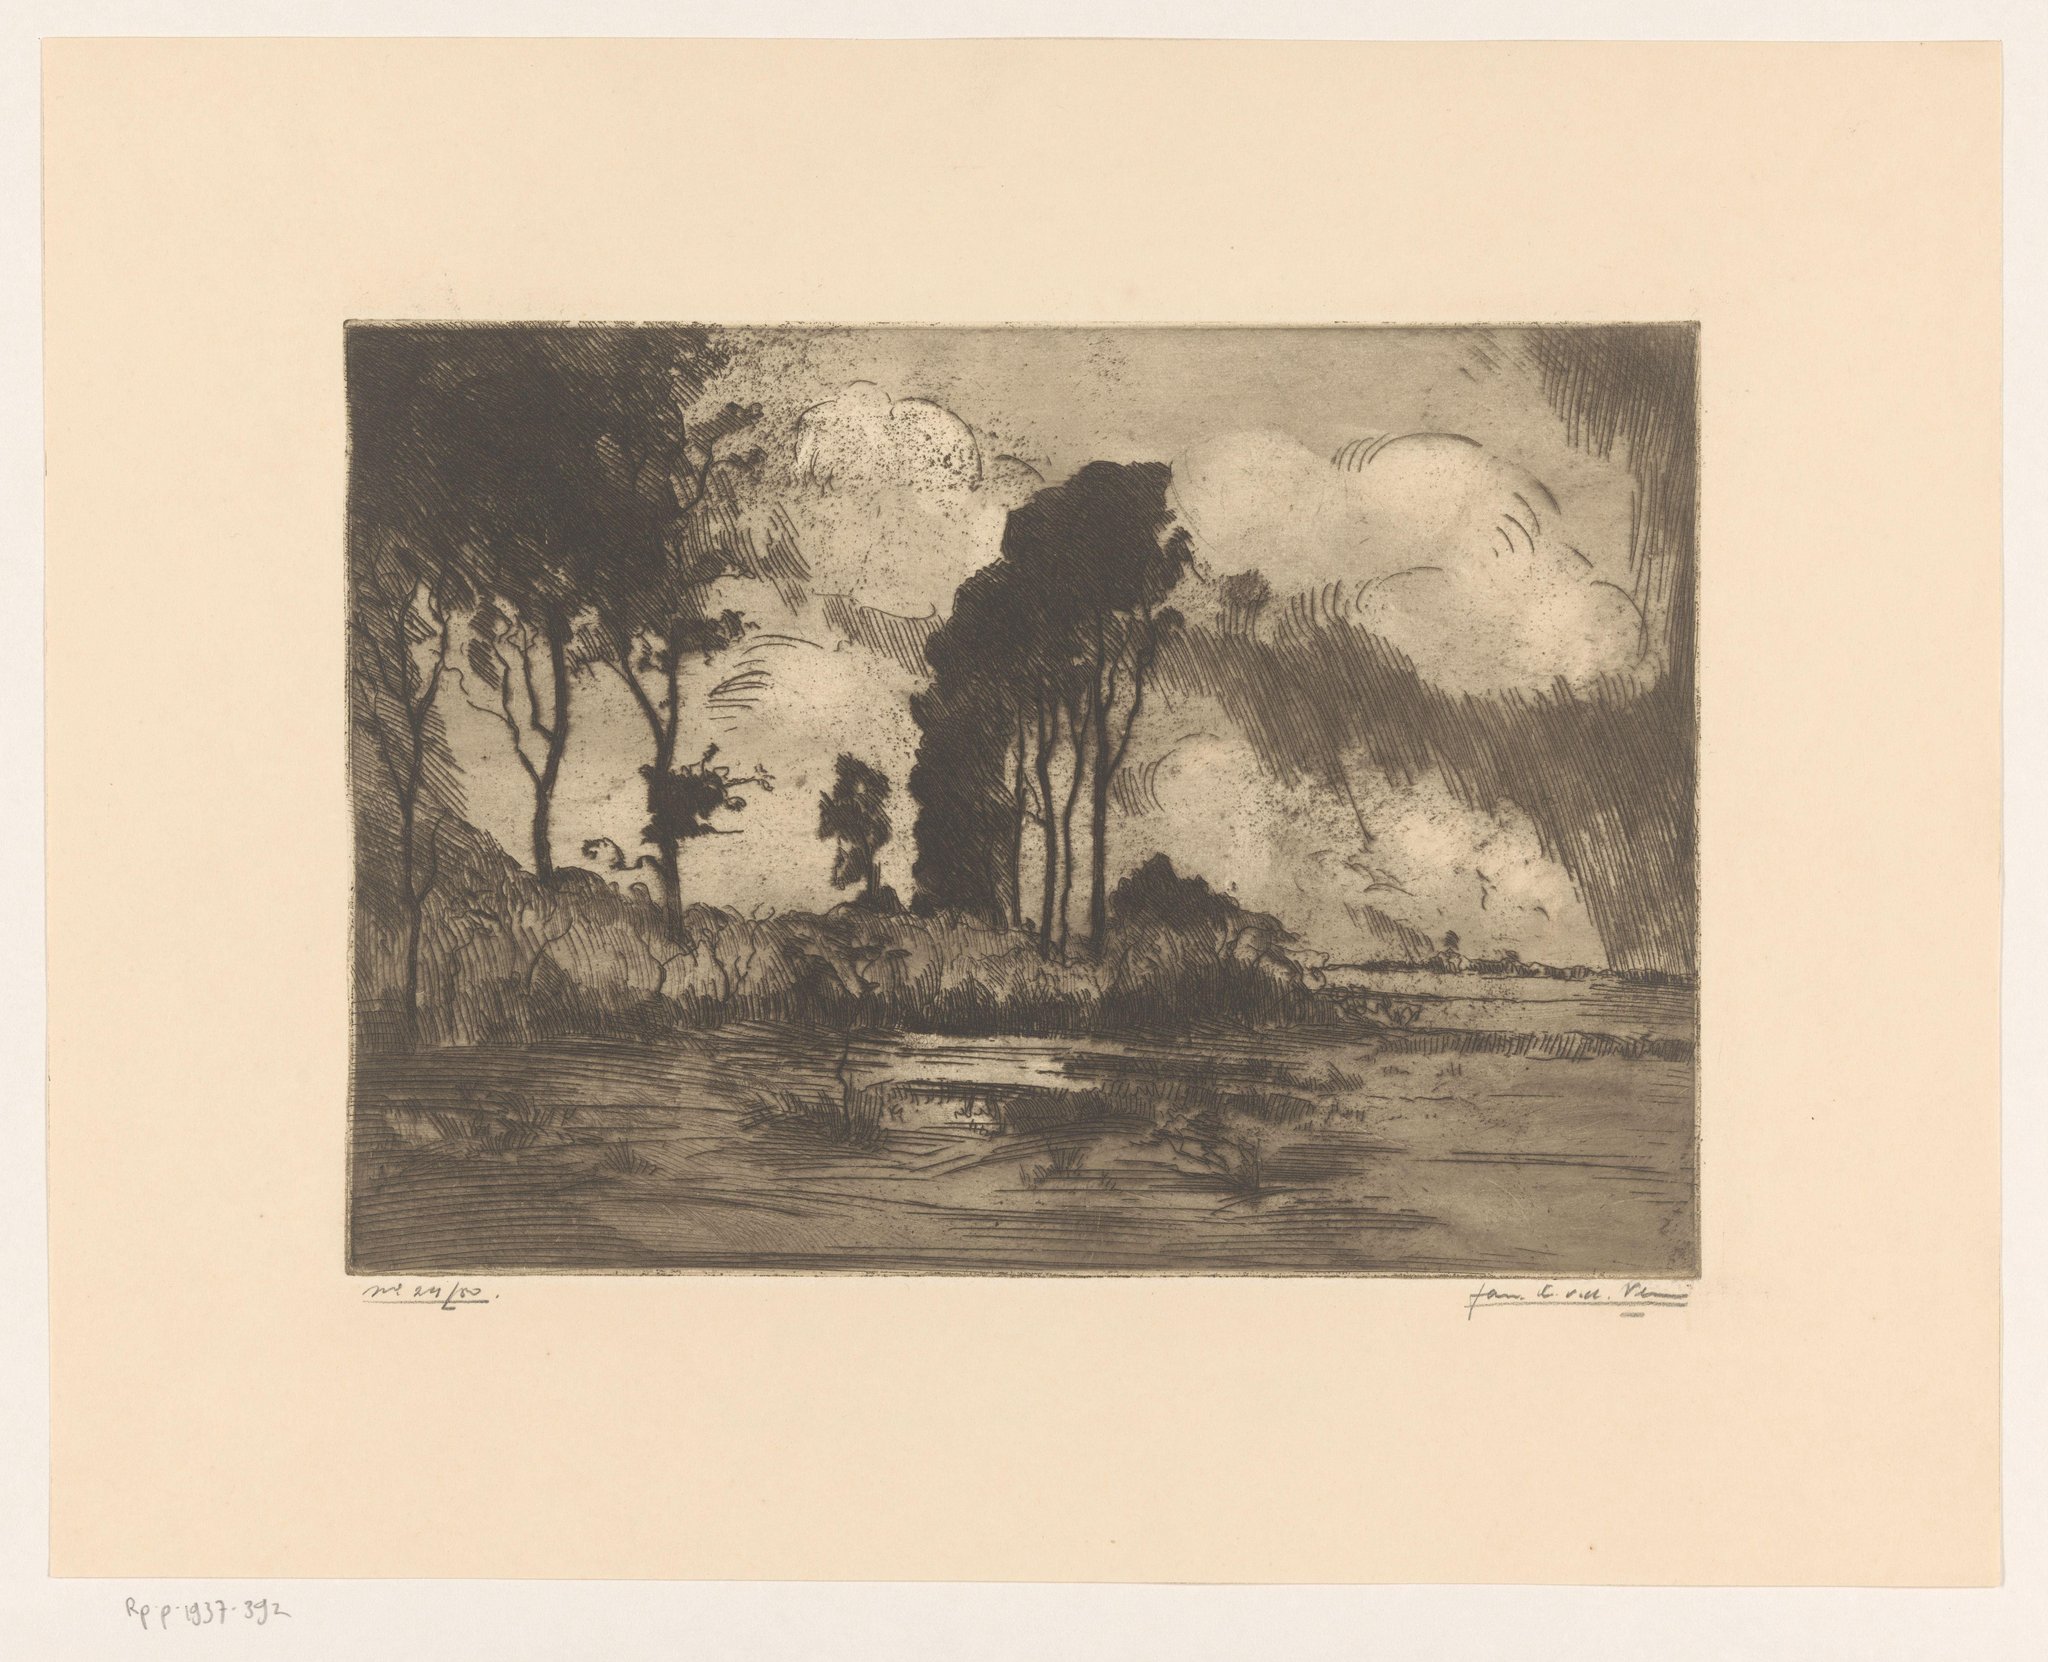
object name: print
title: Landschap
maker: jan c. van der ven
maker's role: draughtsman, print maker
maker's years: 1896-1930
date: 1906-1930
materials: paper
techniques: etching, intaglio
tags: landscapes in the temperate zone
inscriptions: collector's mark: Lugt 2228, annotation: ‘Landschap bij Gorsel’, collector's mark: Lugt 2760